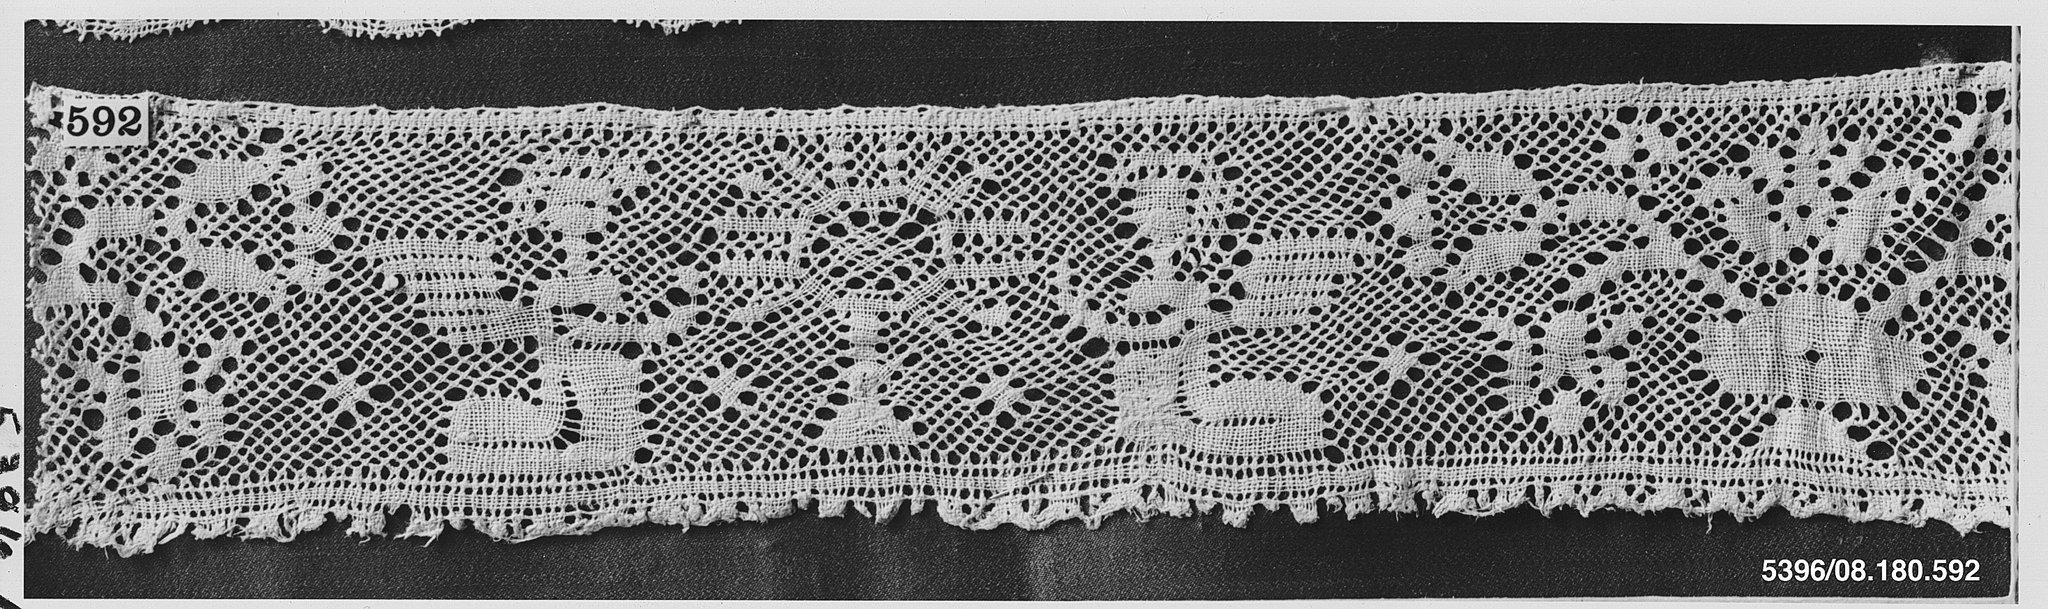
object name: border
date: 1701-1800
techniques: lace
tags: angels